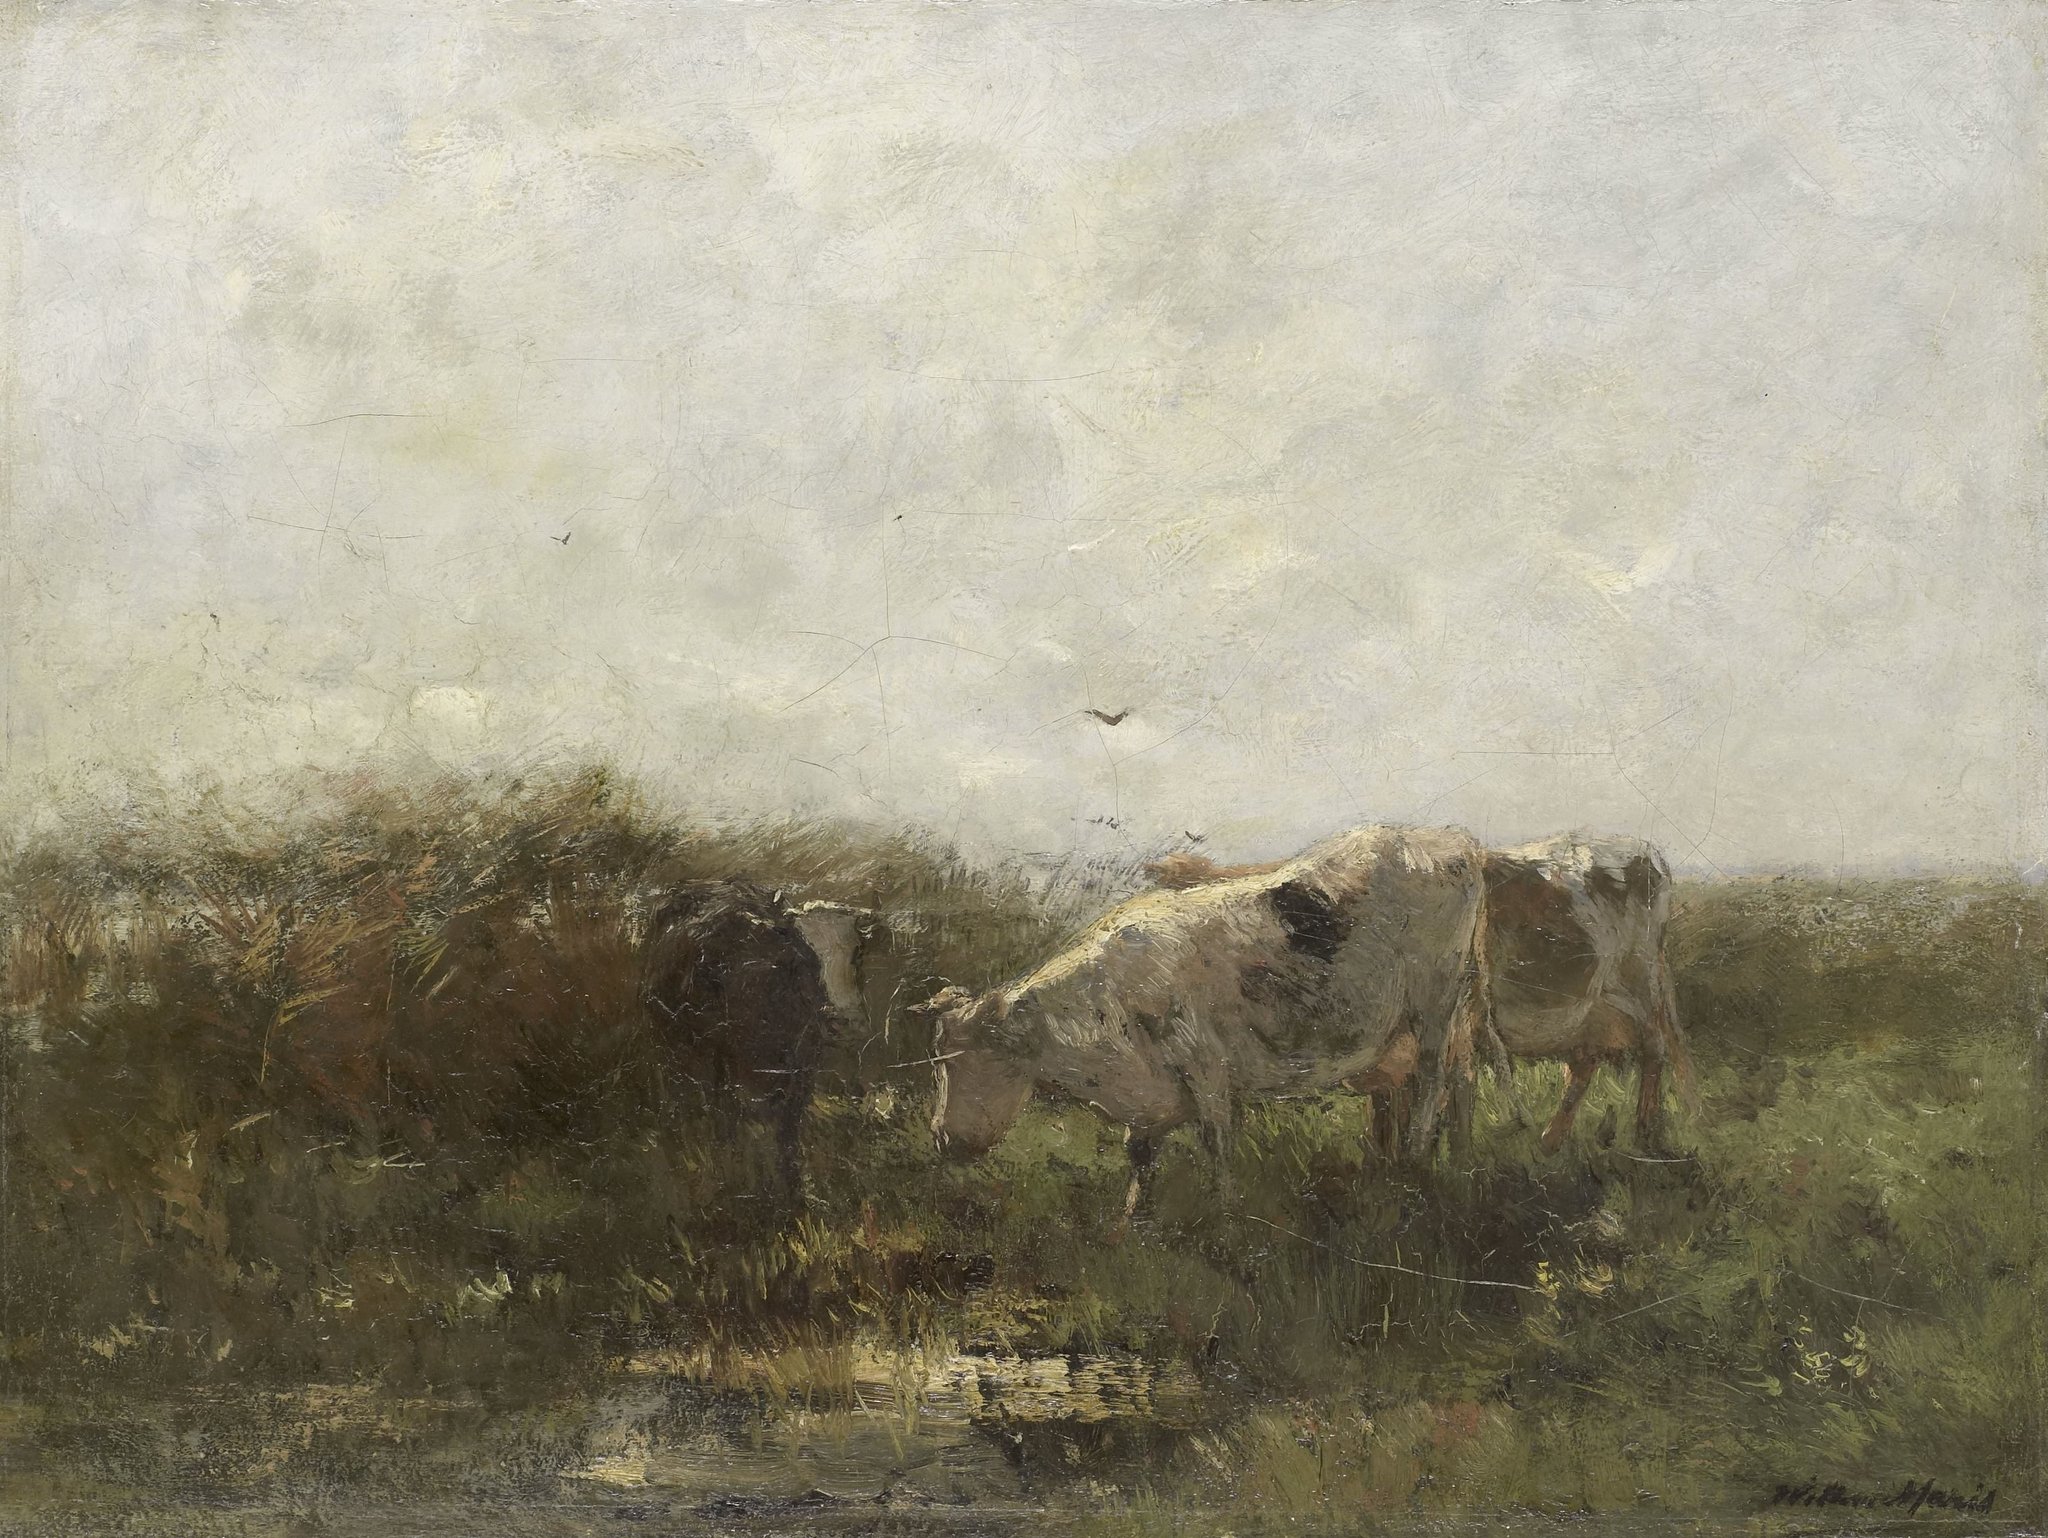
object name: painting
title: Koeien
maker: willem maris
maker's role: draughtsman, painter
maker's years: 1844-1910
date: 1880-1904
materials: canvas, oil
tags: cow, meadow, pasture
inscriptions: signature: ‘Willem Maris’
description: Een groepje grazende koeien in een weiland, links een sloot.